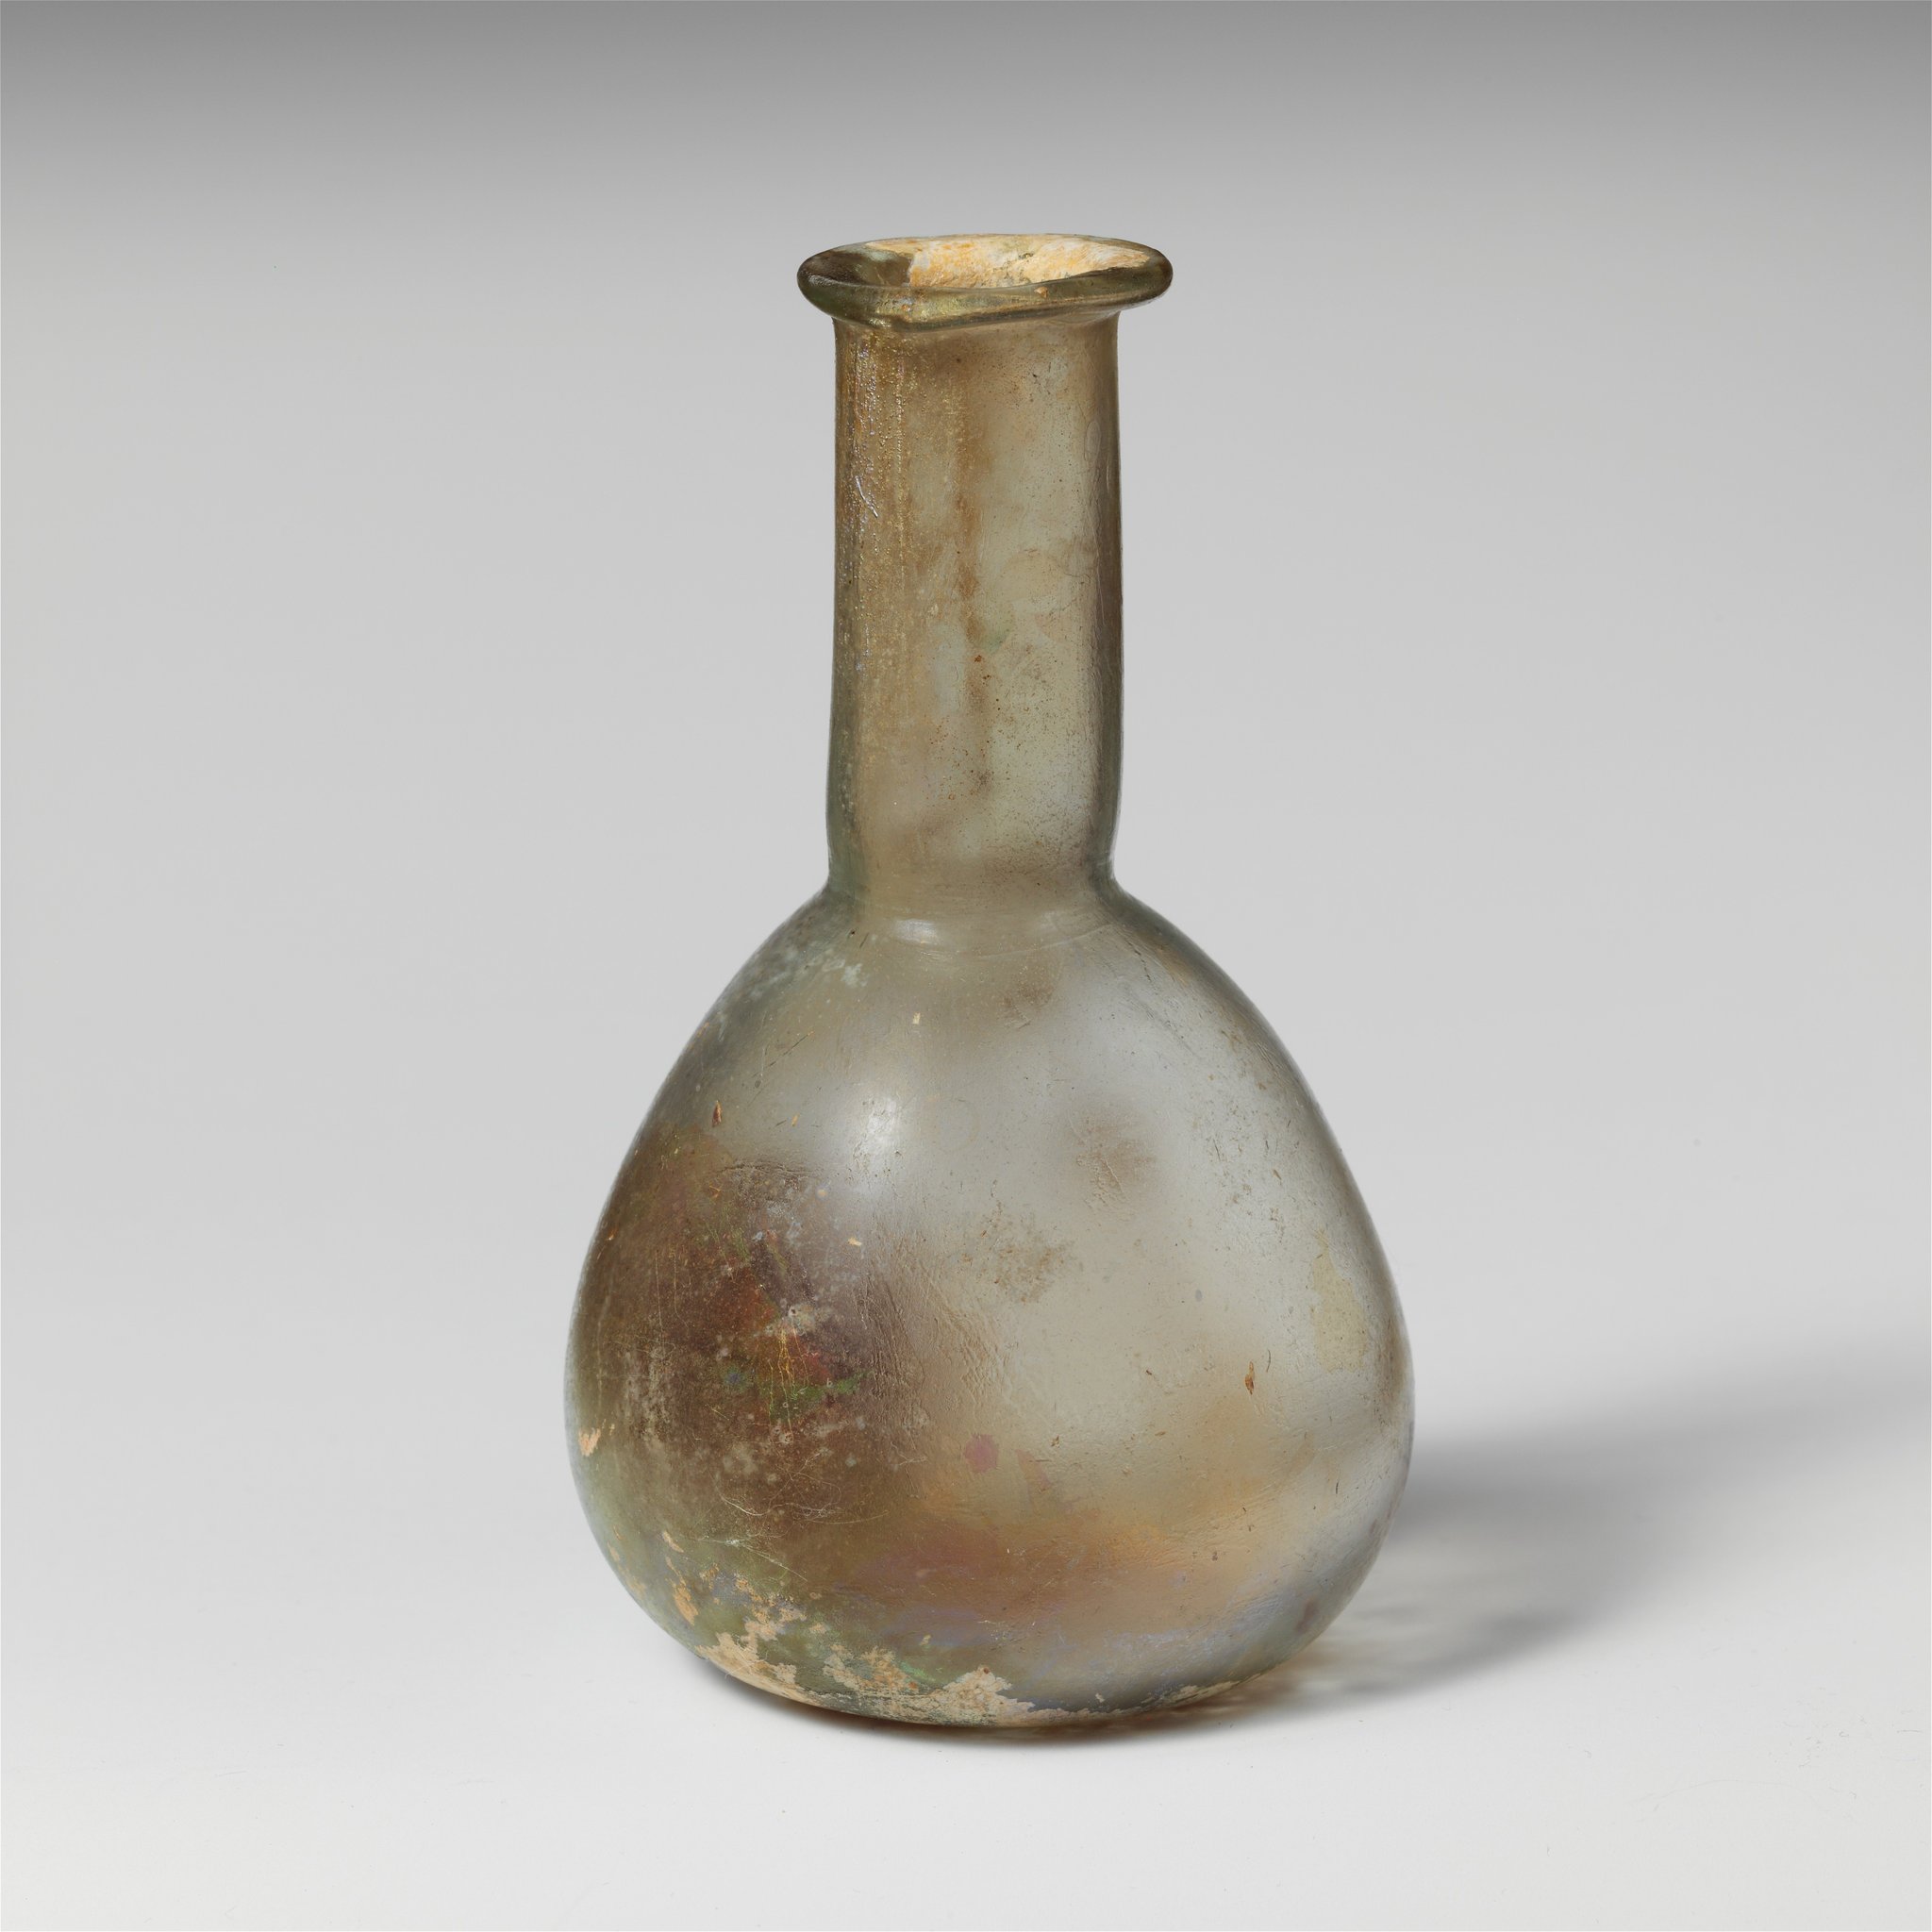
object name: perfume bottle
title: Glass perfume bottle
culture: roman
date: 1-100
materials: glass